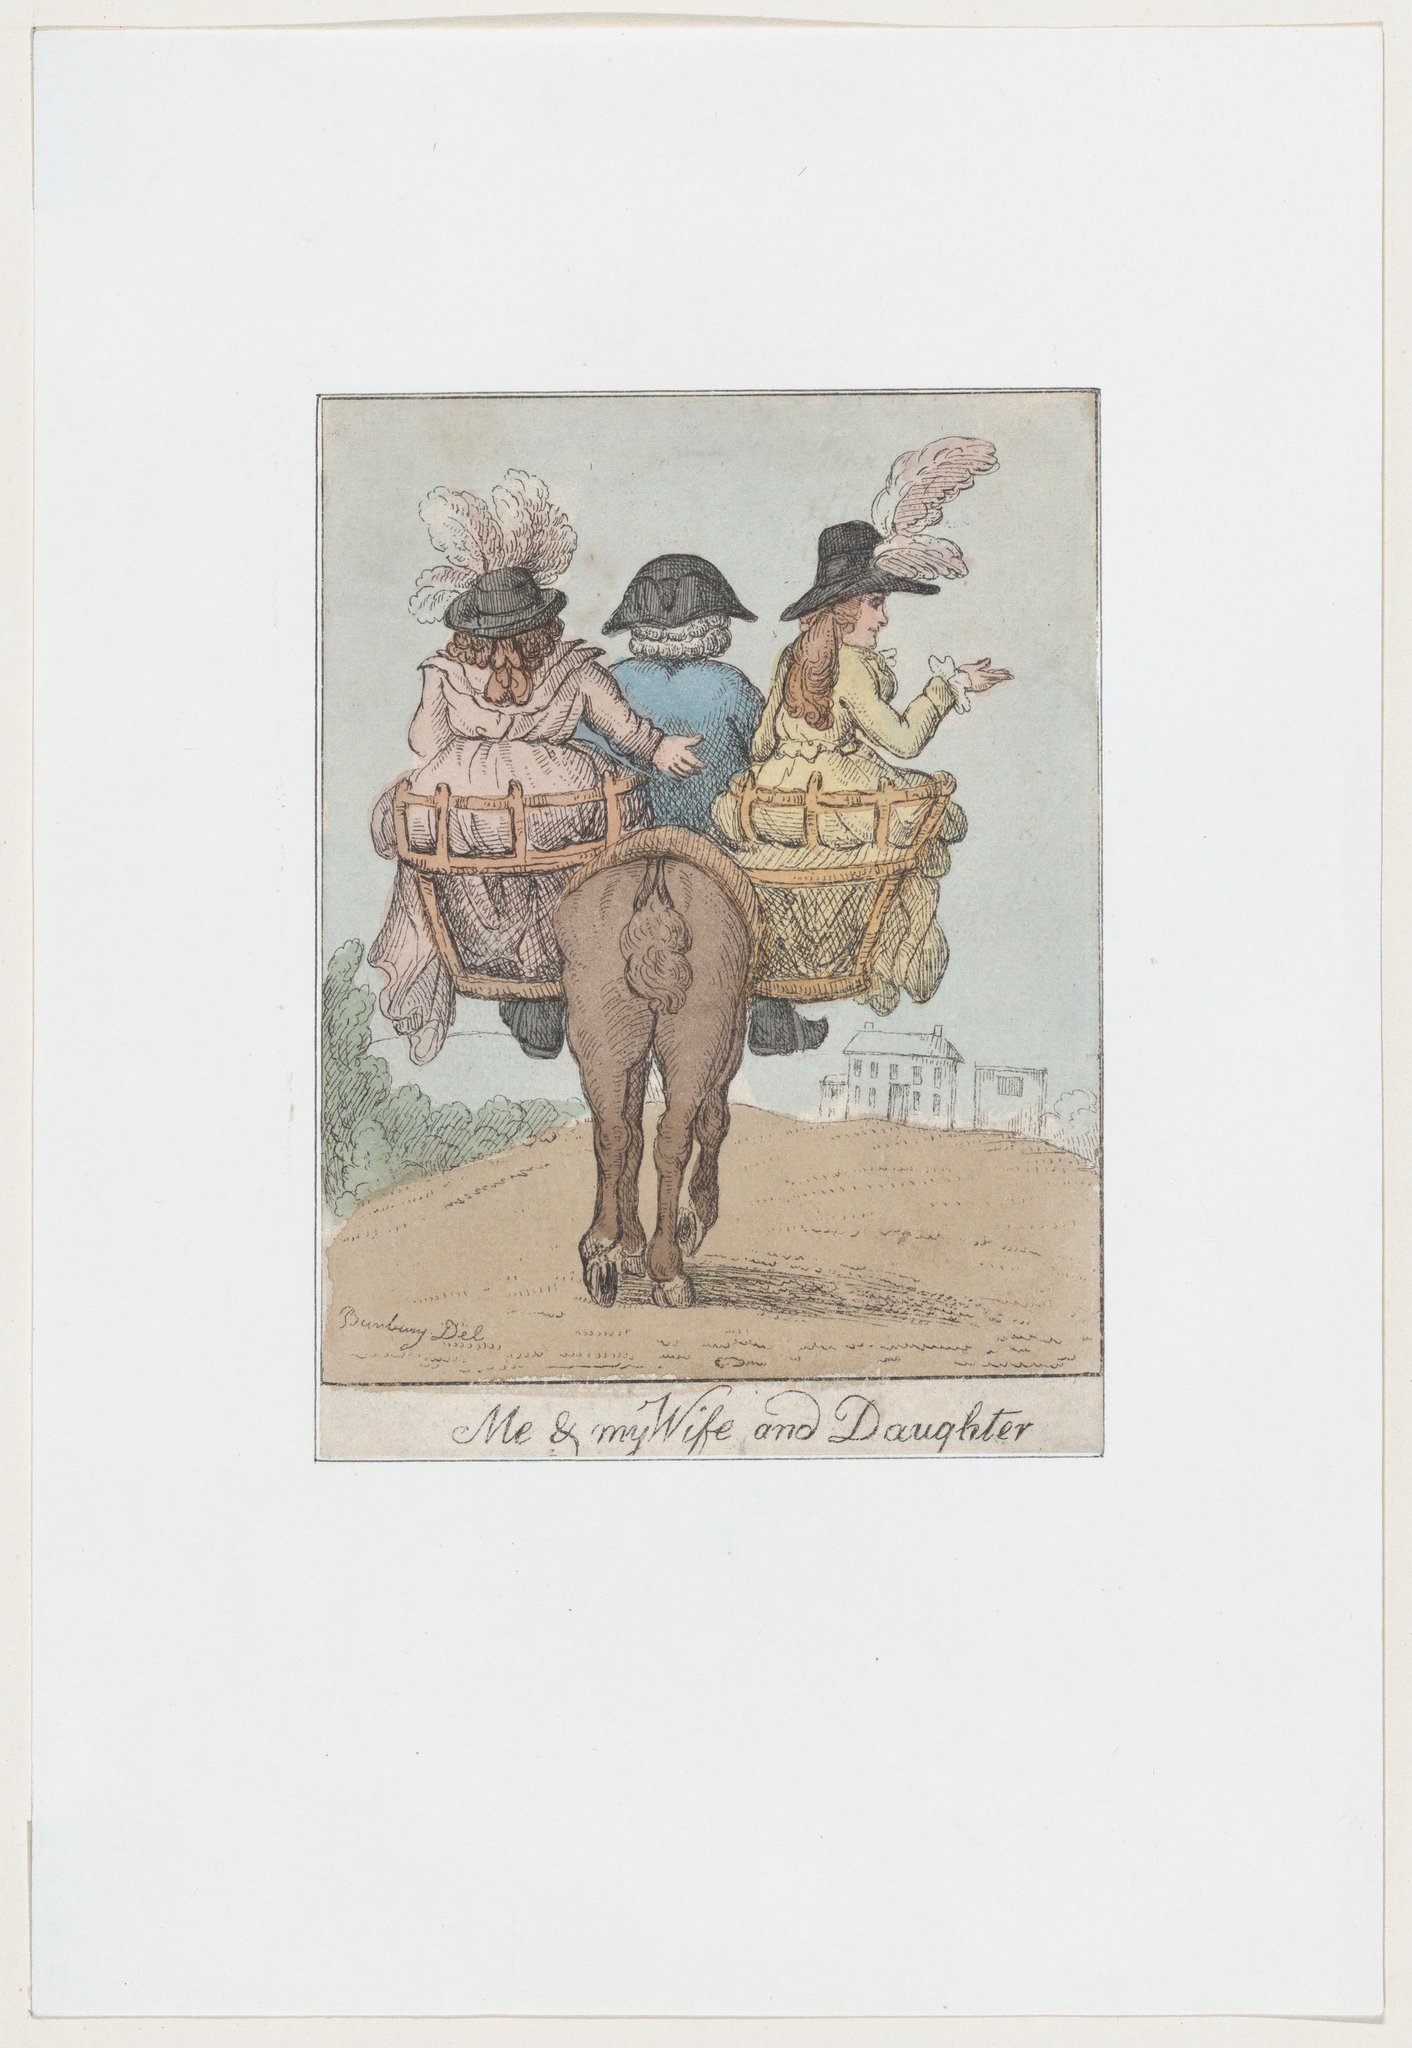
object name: print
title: Me and My Wife and Daughter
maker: henry william bunbury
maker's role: artist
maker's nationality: british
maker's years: 1750-1811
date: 1780-1800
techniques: etching, hand coloring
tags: men,women,horses,family